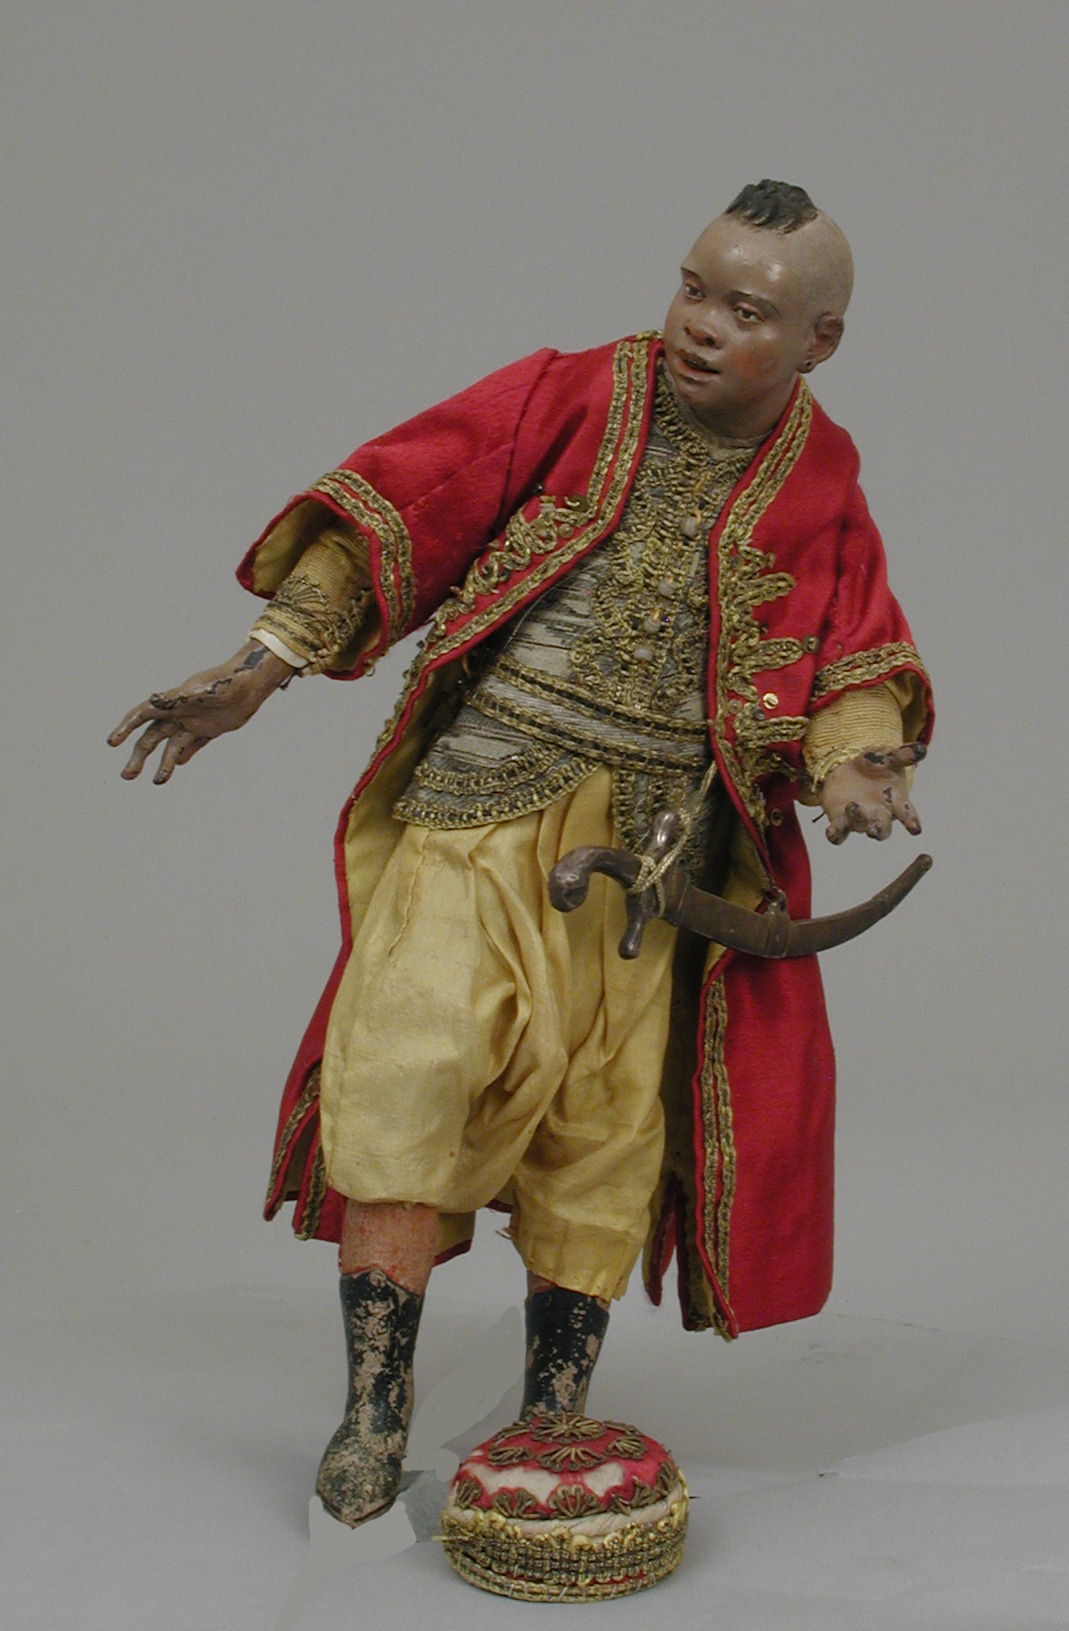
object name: crèche figure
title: King's attendant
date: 1751-1800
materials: brass, cotton, glass, textile, silk, thread, terracotta, fiber, metal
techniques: polychrome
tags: swords,men